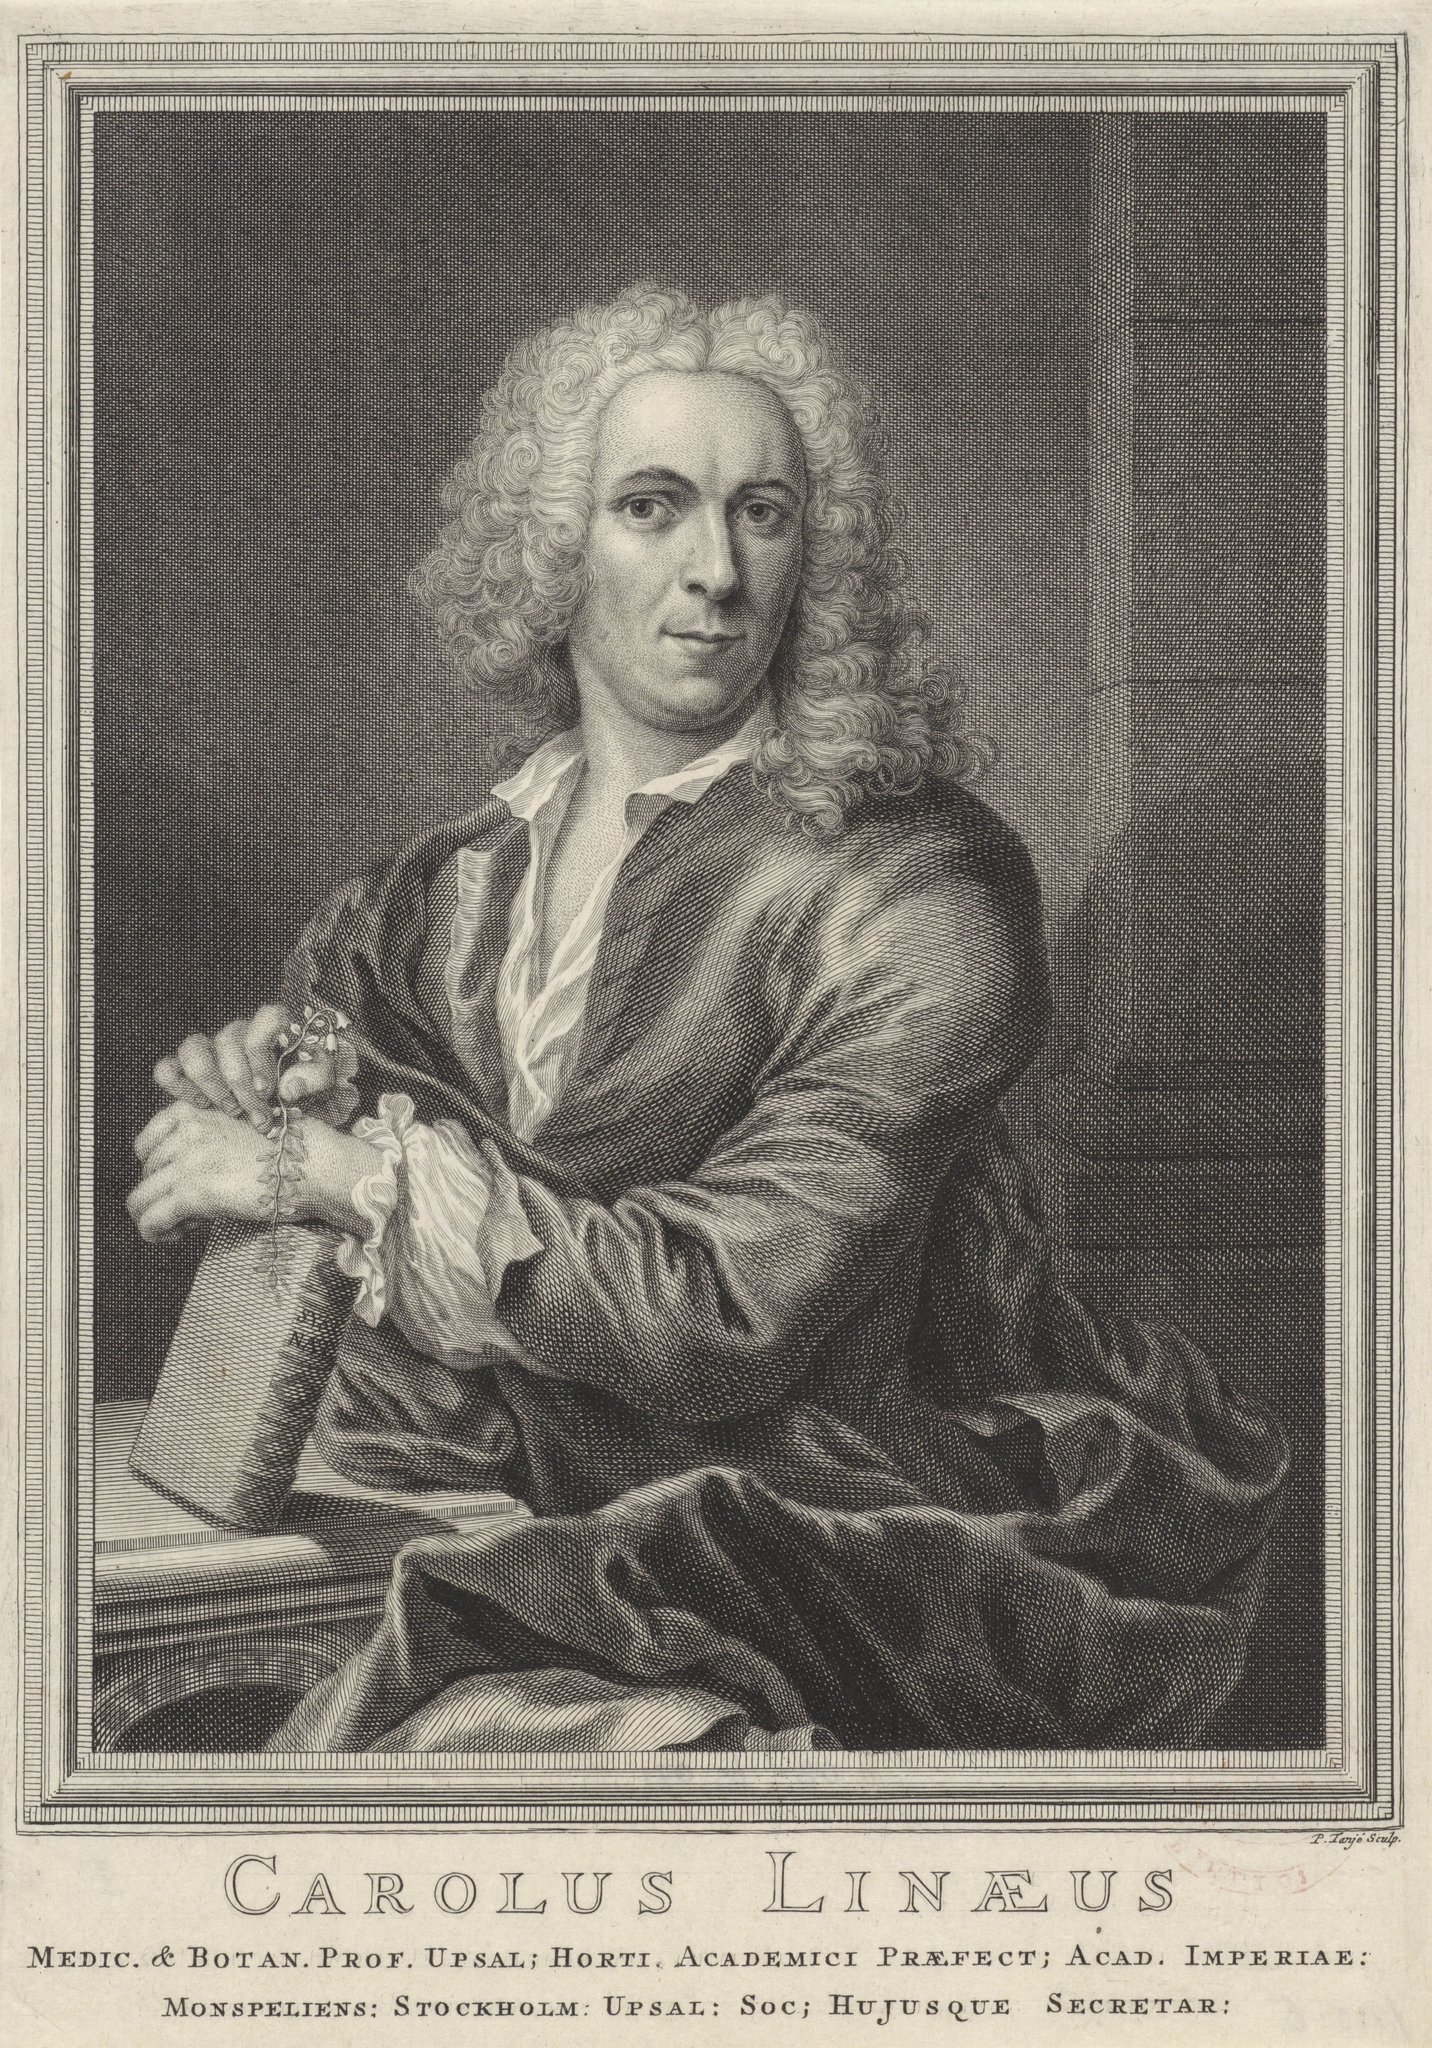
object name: print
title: Portret van Carolus Linaeus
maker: pieter tanjé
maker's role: draughtsman, print maker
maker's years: 1706-1761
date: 1716-1761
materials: paper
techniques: engraving, etching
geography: amsterdam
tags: carl linnaeus, flowers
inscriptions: collector's mark: Lugt 240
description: Portret van botanicus Carolus Linaeus, zijn handen rustend op zijn boek Systema Naturae.